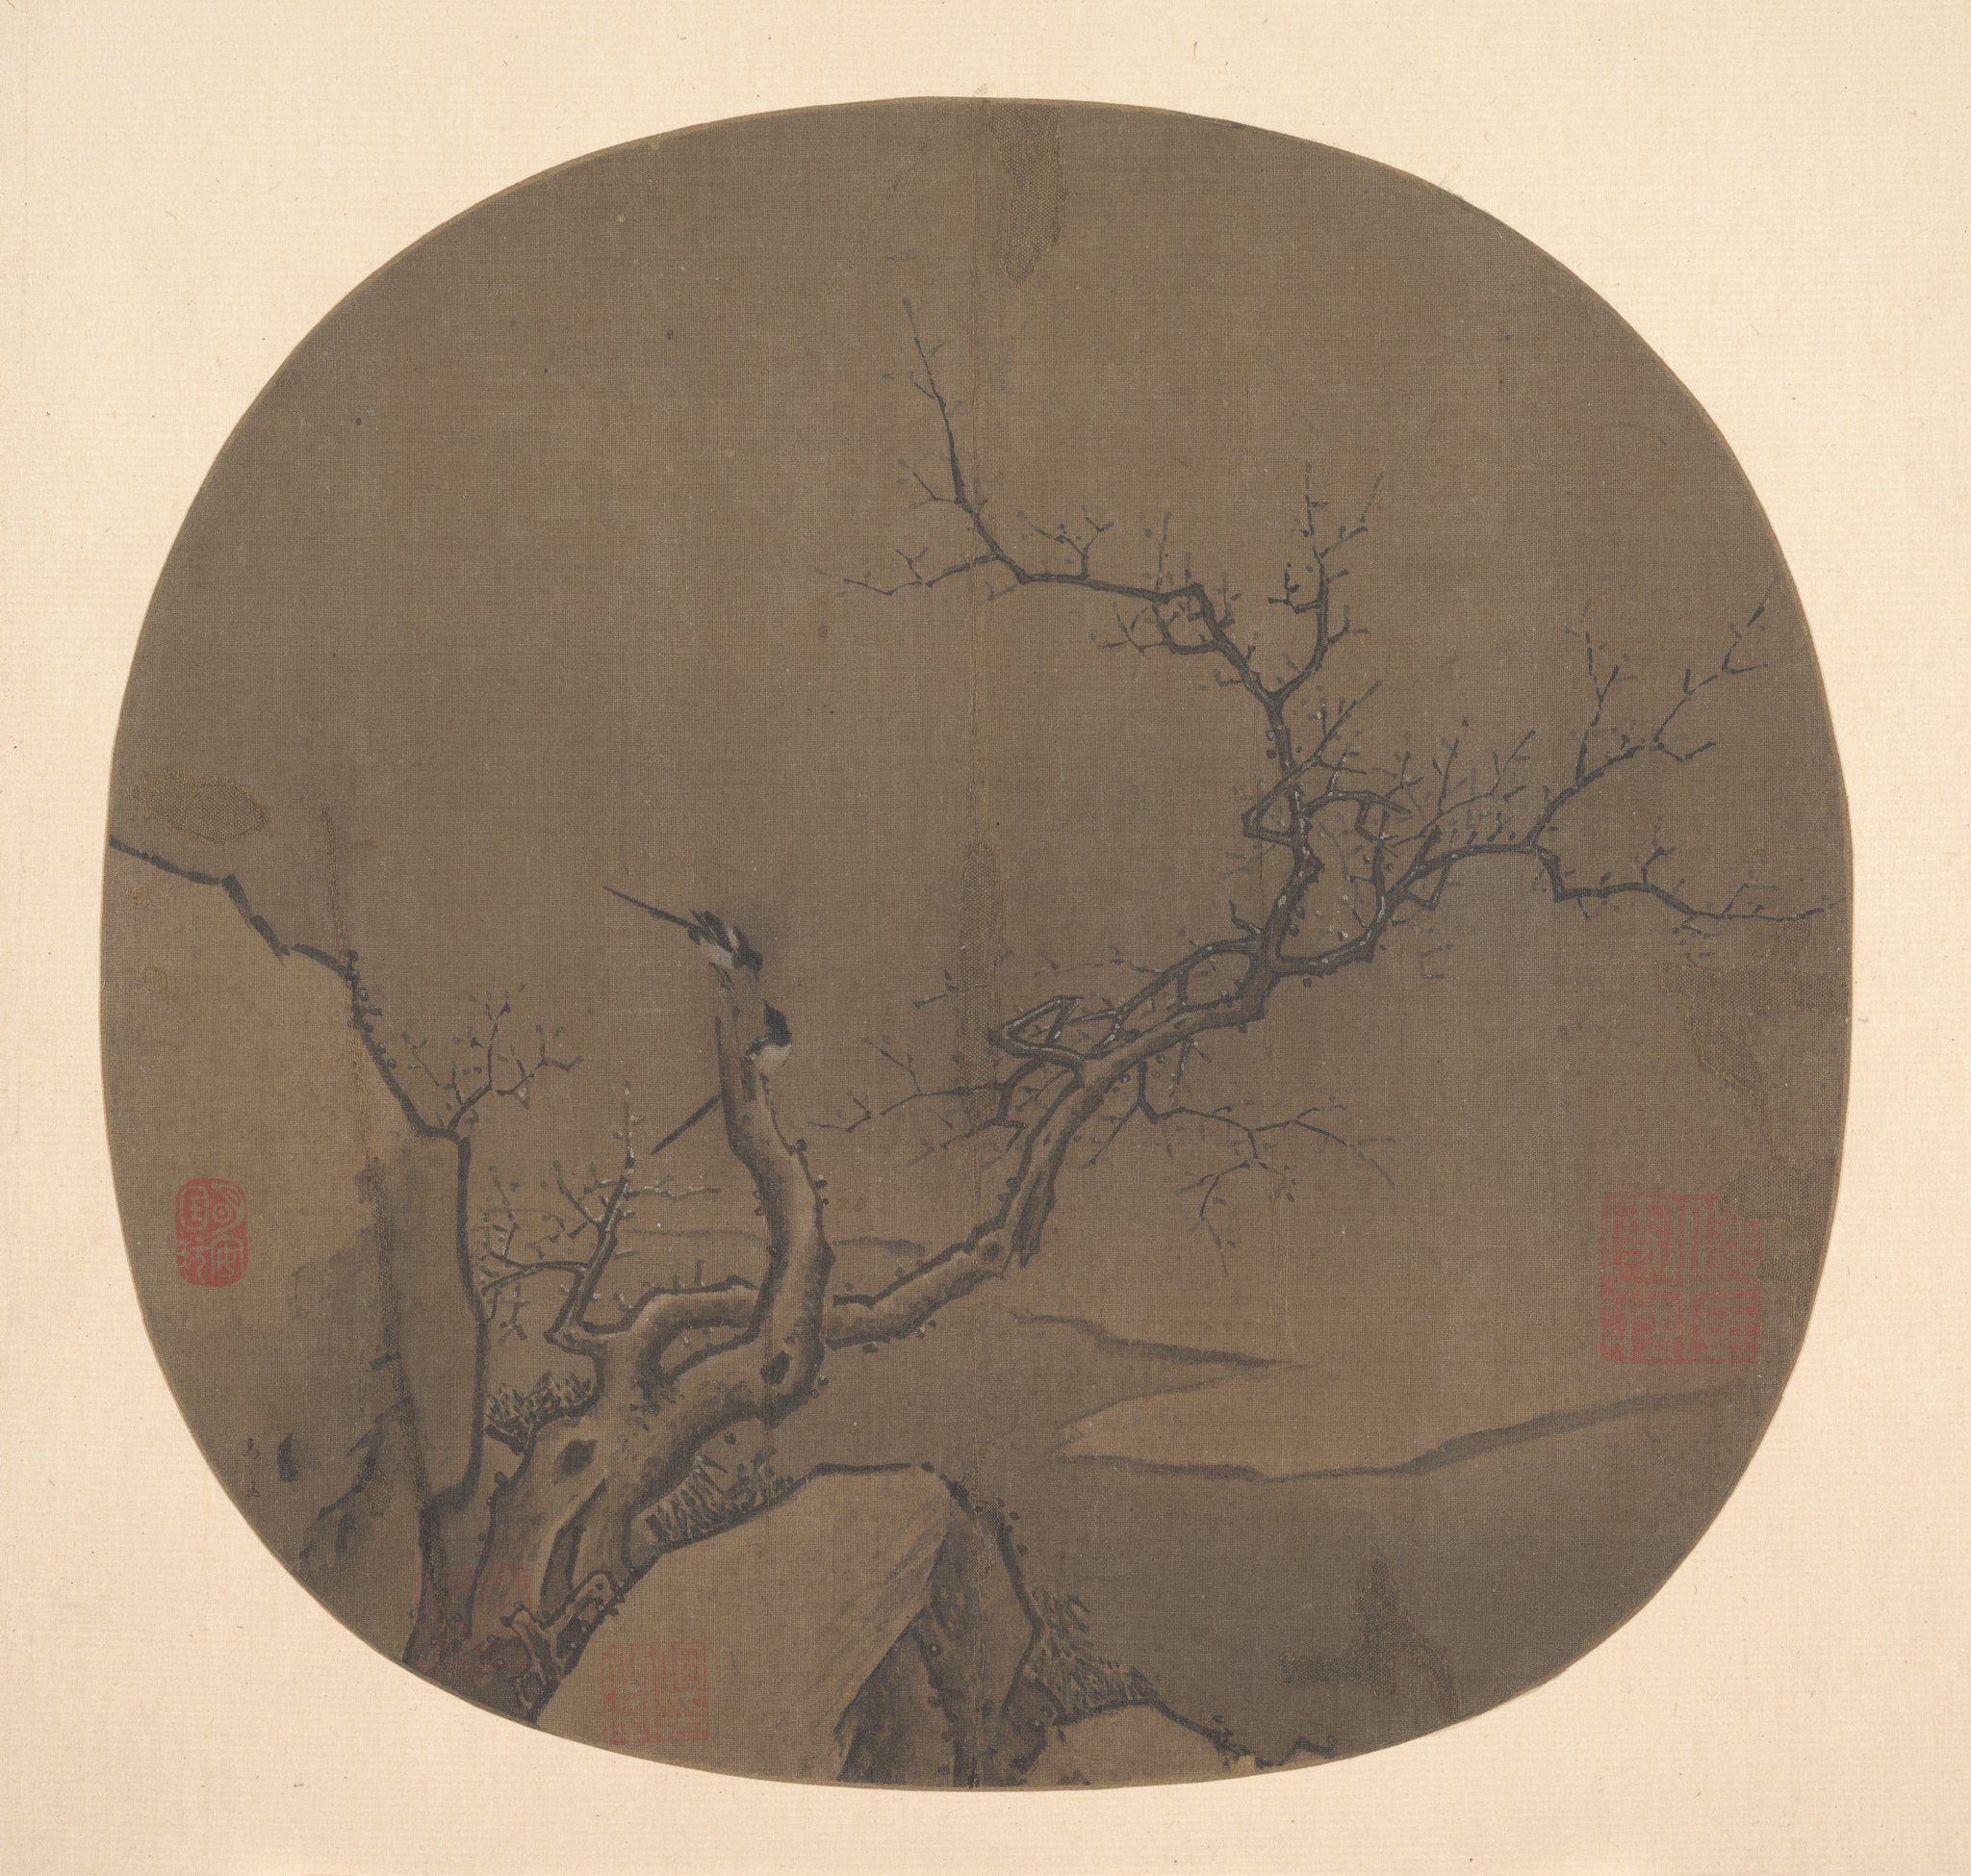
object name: fan mounted a an album leaf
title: Wintery Bough and Magpies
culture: chinese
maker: unidentified artist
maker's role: artist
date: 1368-1911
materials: ink, pigment, silk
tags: birds,trees